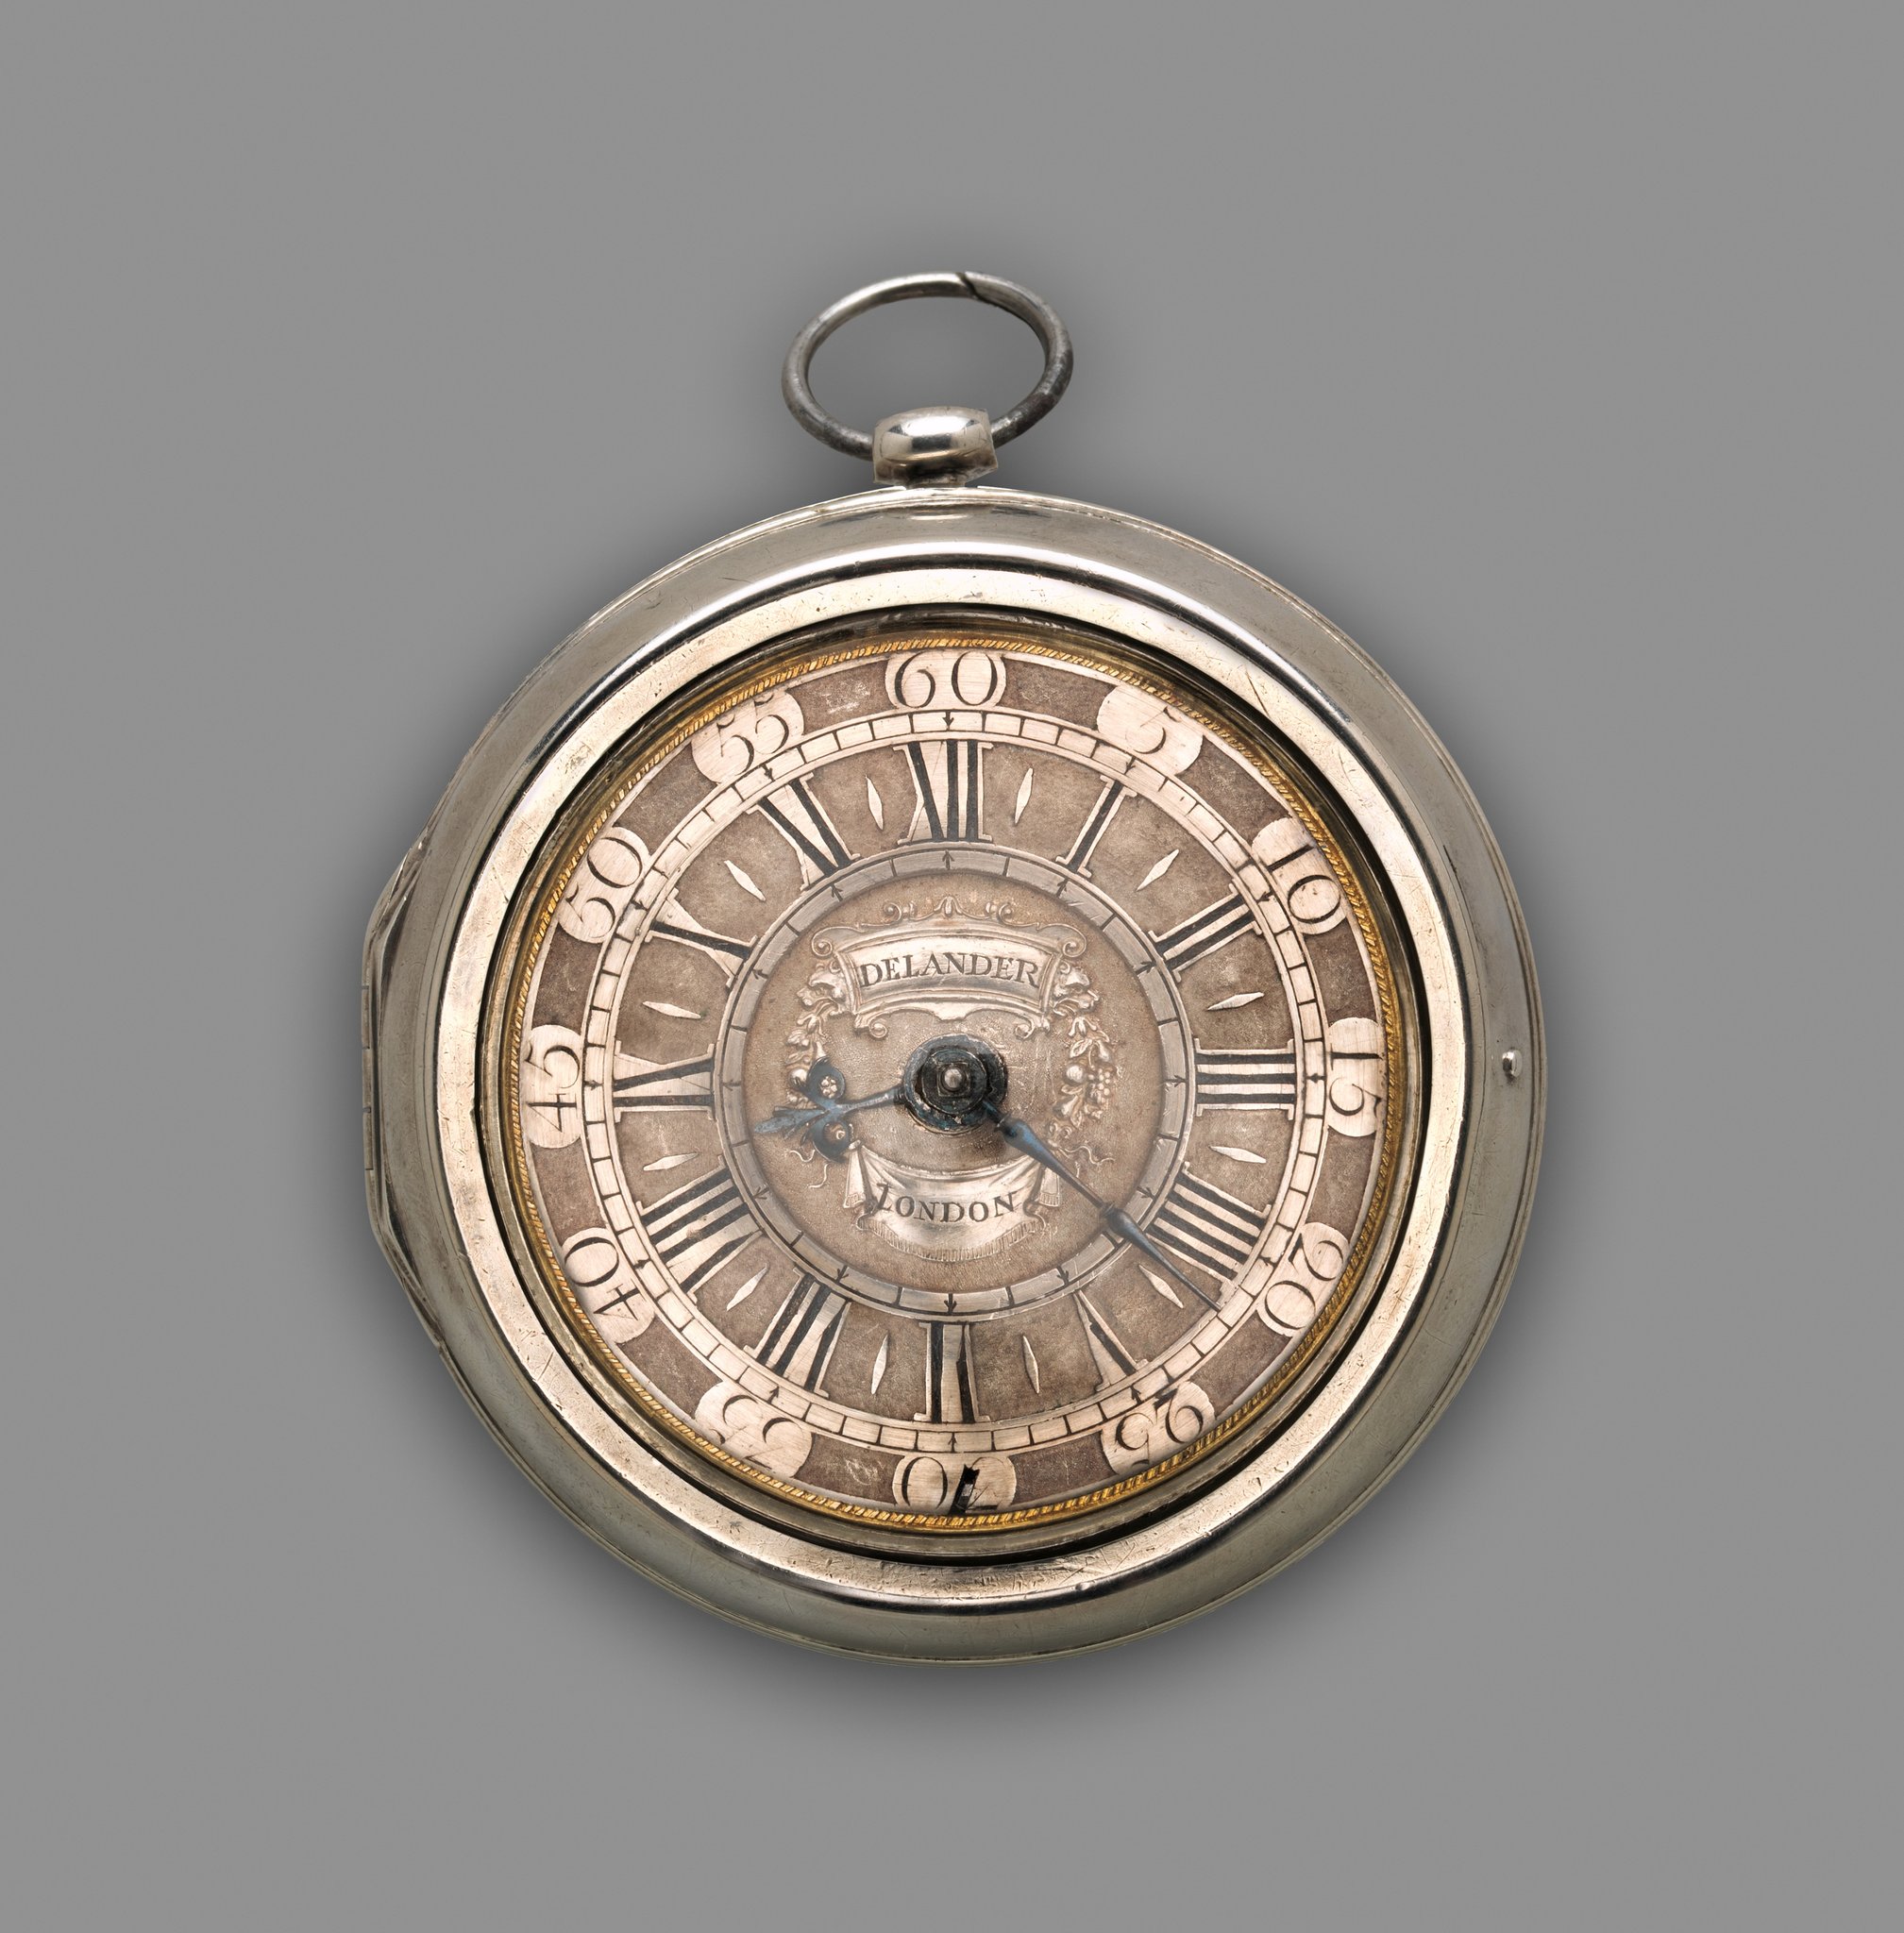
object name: pair case watch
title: Pair-case watch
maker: daniel delander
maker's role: maker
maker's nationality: british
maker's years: 1678-1733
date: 1715-1719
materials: diamond, gilt brass, silver, steel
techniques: enamel